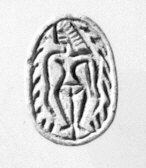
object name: stamp seal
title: Scarab seal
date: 1700-1560 BCE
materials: stone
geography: levant